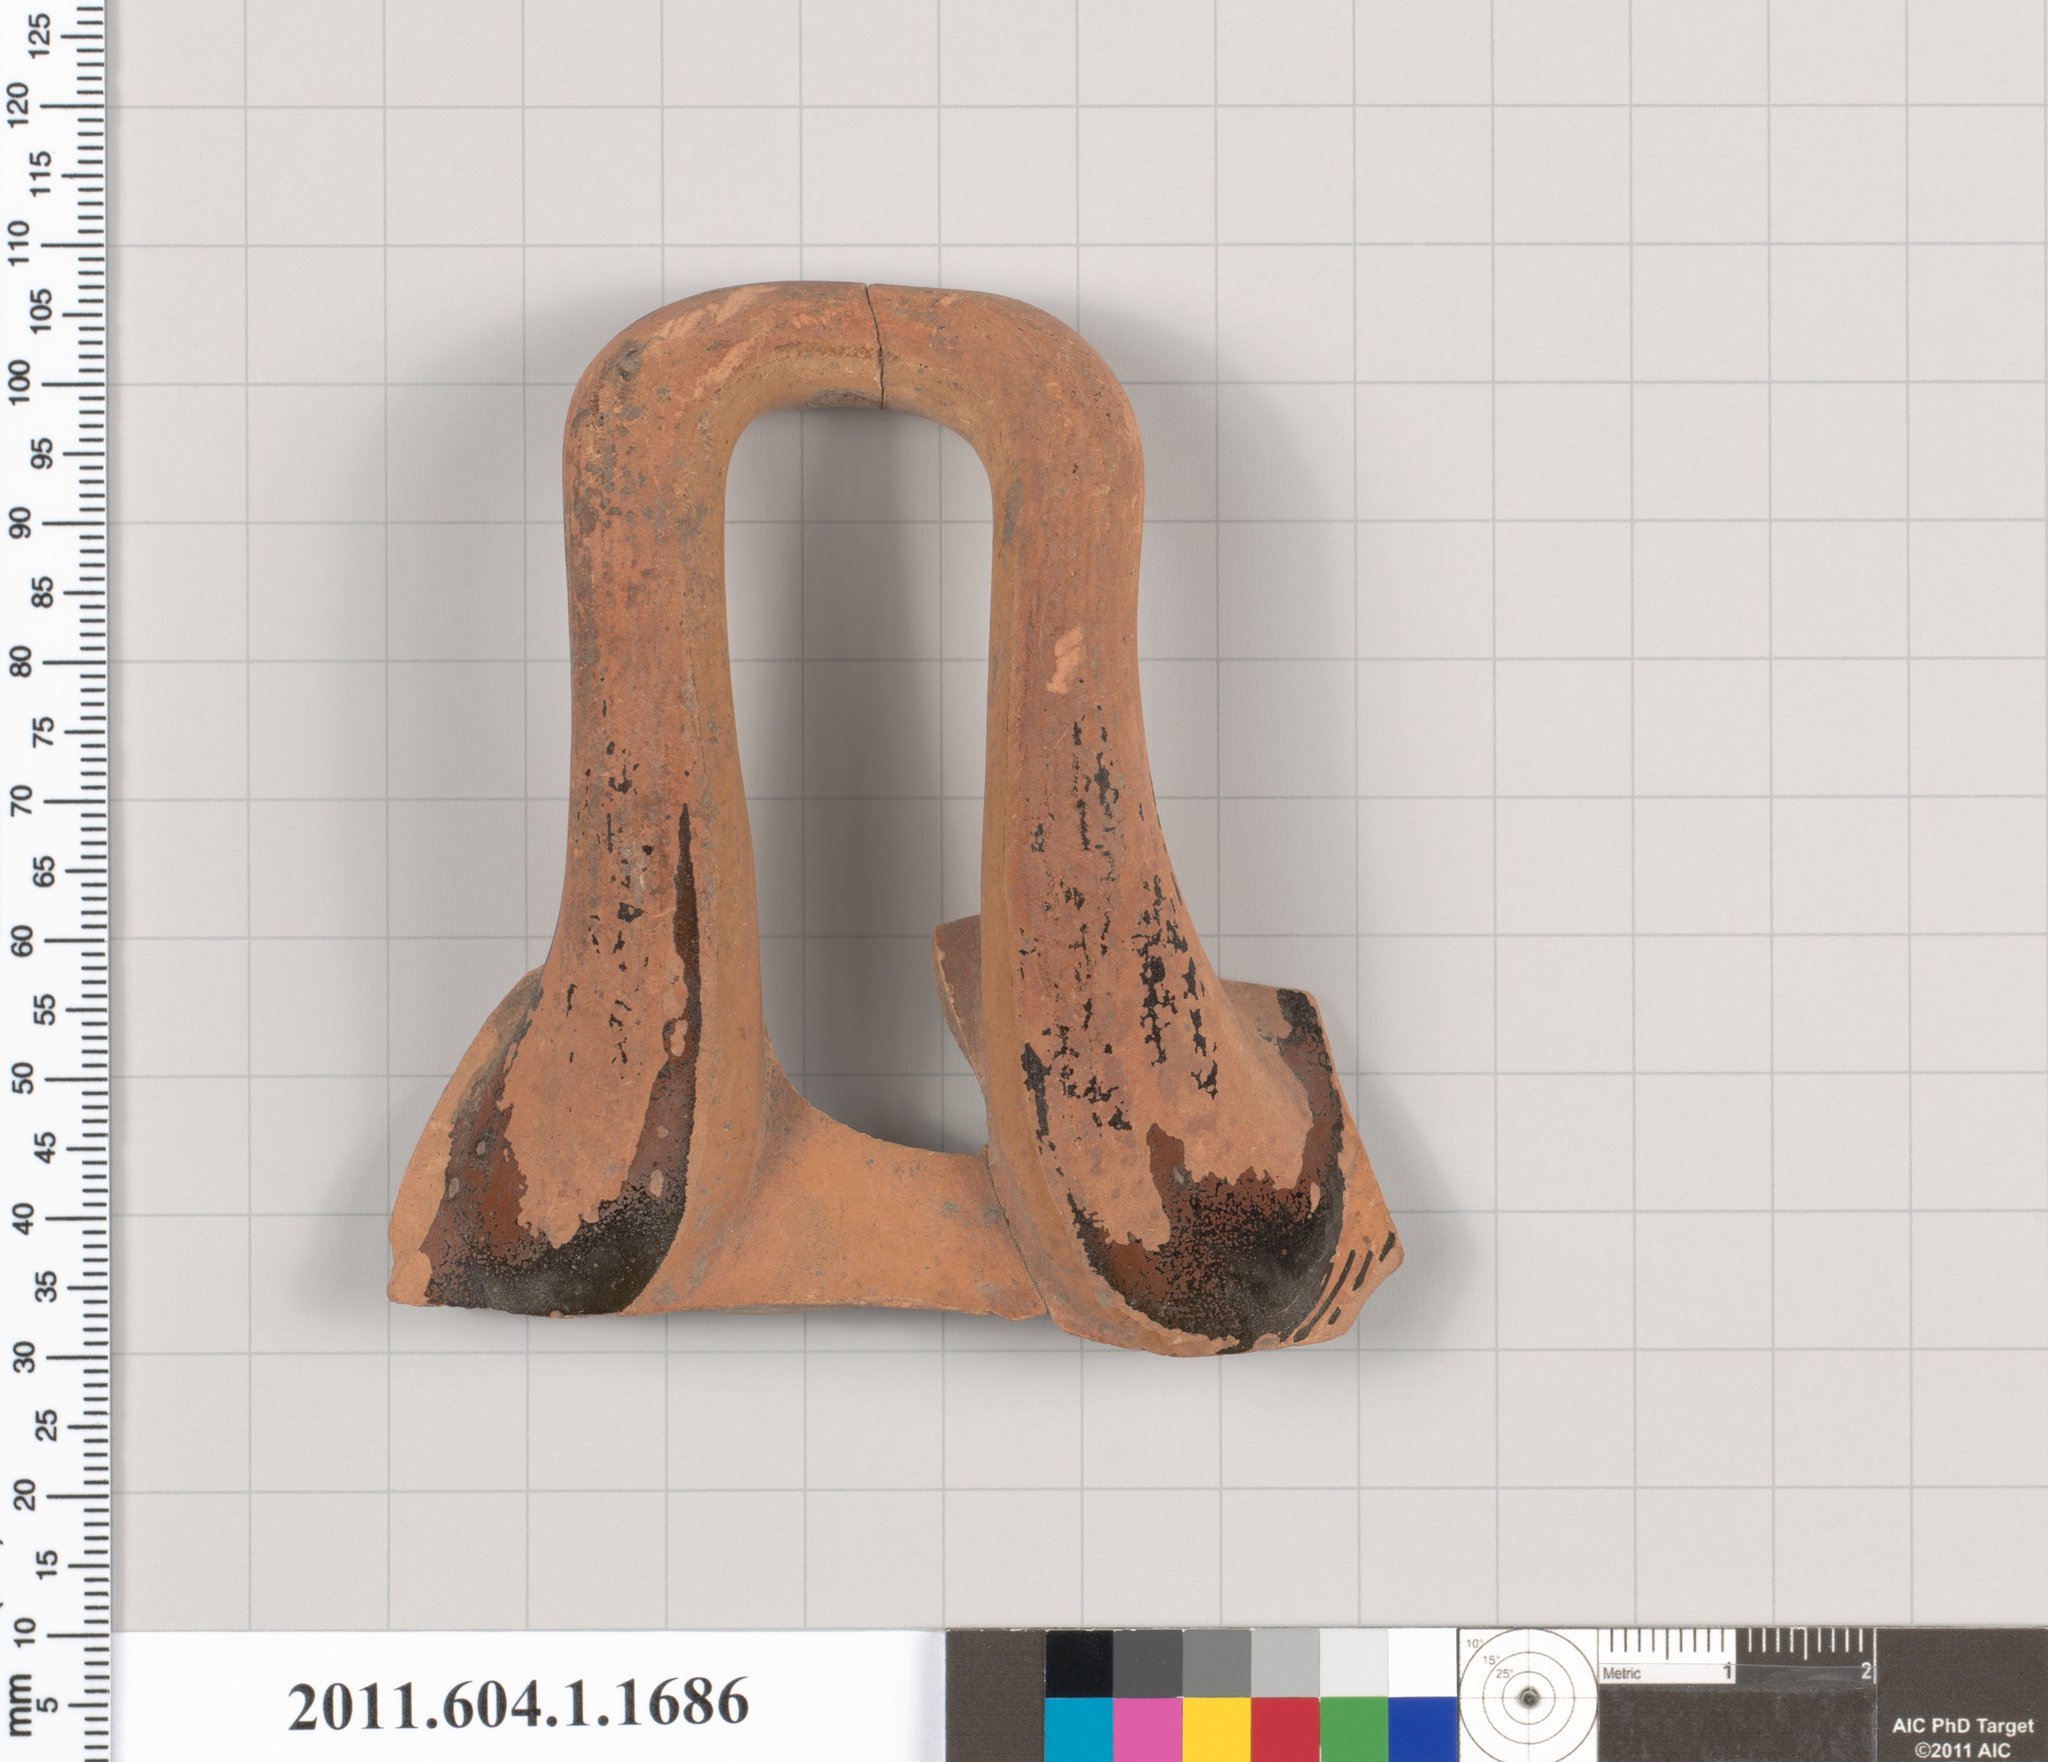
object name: kylix fragment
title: Terracotta fragment of a kylix (drinking cup)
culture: greek, attic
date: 500-401 BCE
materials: terracotta